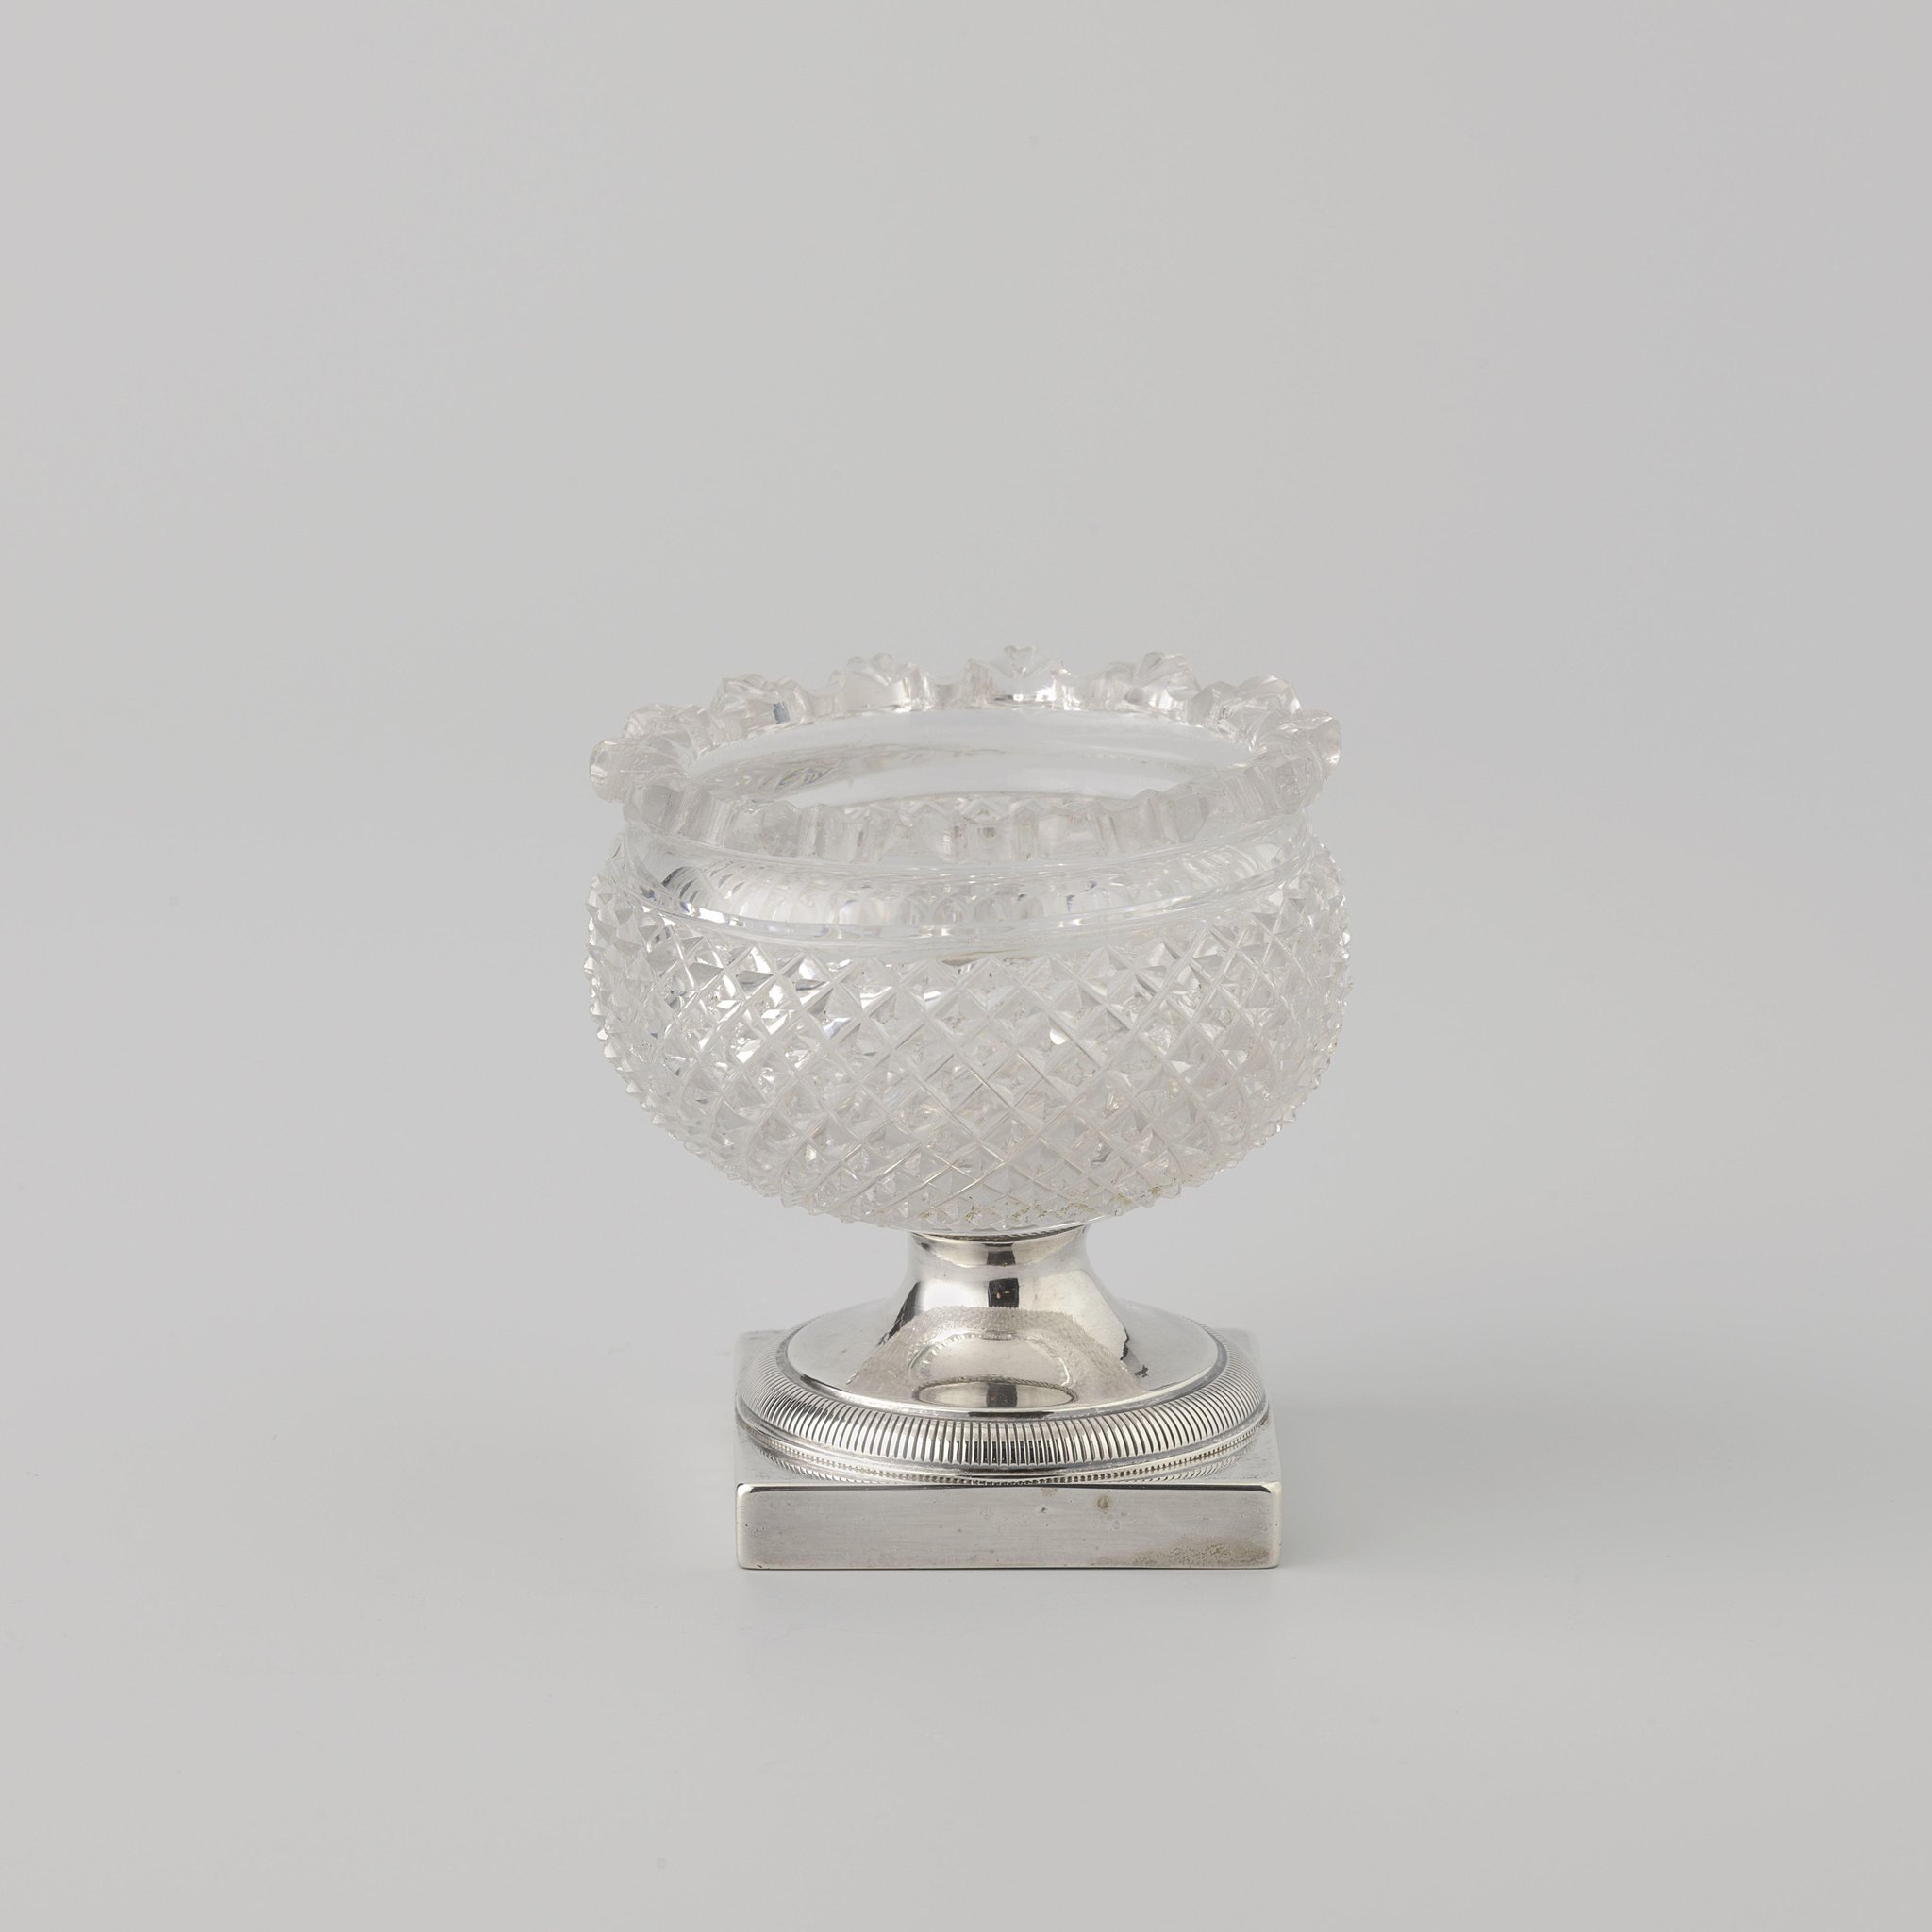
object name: salt condiment vessel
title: Zoutvat bolvormig op vierkante voet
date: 1830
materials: glass, gypsum, silver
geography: amsterdam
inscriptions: assay office mark, alloy mark, date letter: ‘V’, maker's mark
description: De vier bolvormige vaatjes van kleurloos glas, met uitgebogen rand, rusten elk op een ronde, gewelfde, zich verjongende voet op een vierkant basement. Aan de onderzijde van de voet loopt een geribde band en aan de bovenzijde een kabelrand. Het vat is geslepen in een motief van diamanten, de geschulpte rand in facetten. De voet is met gips opgevuld.